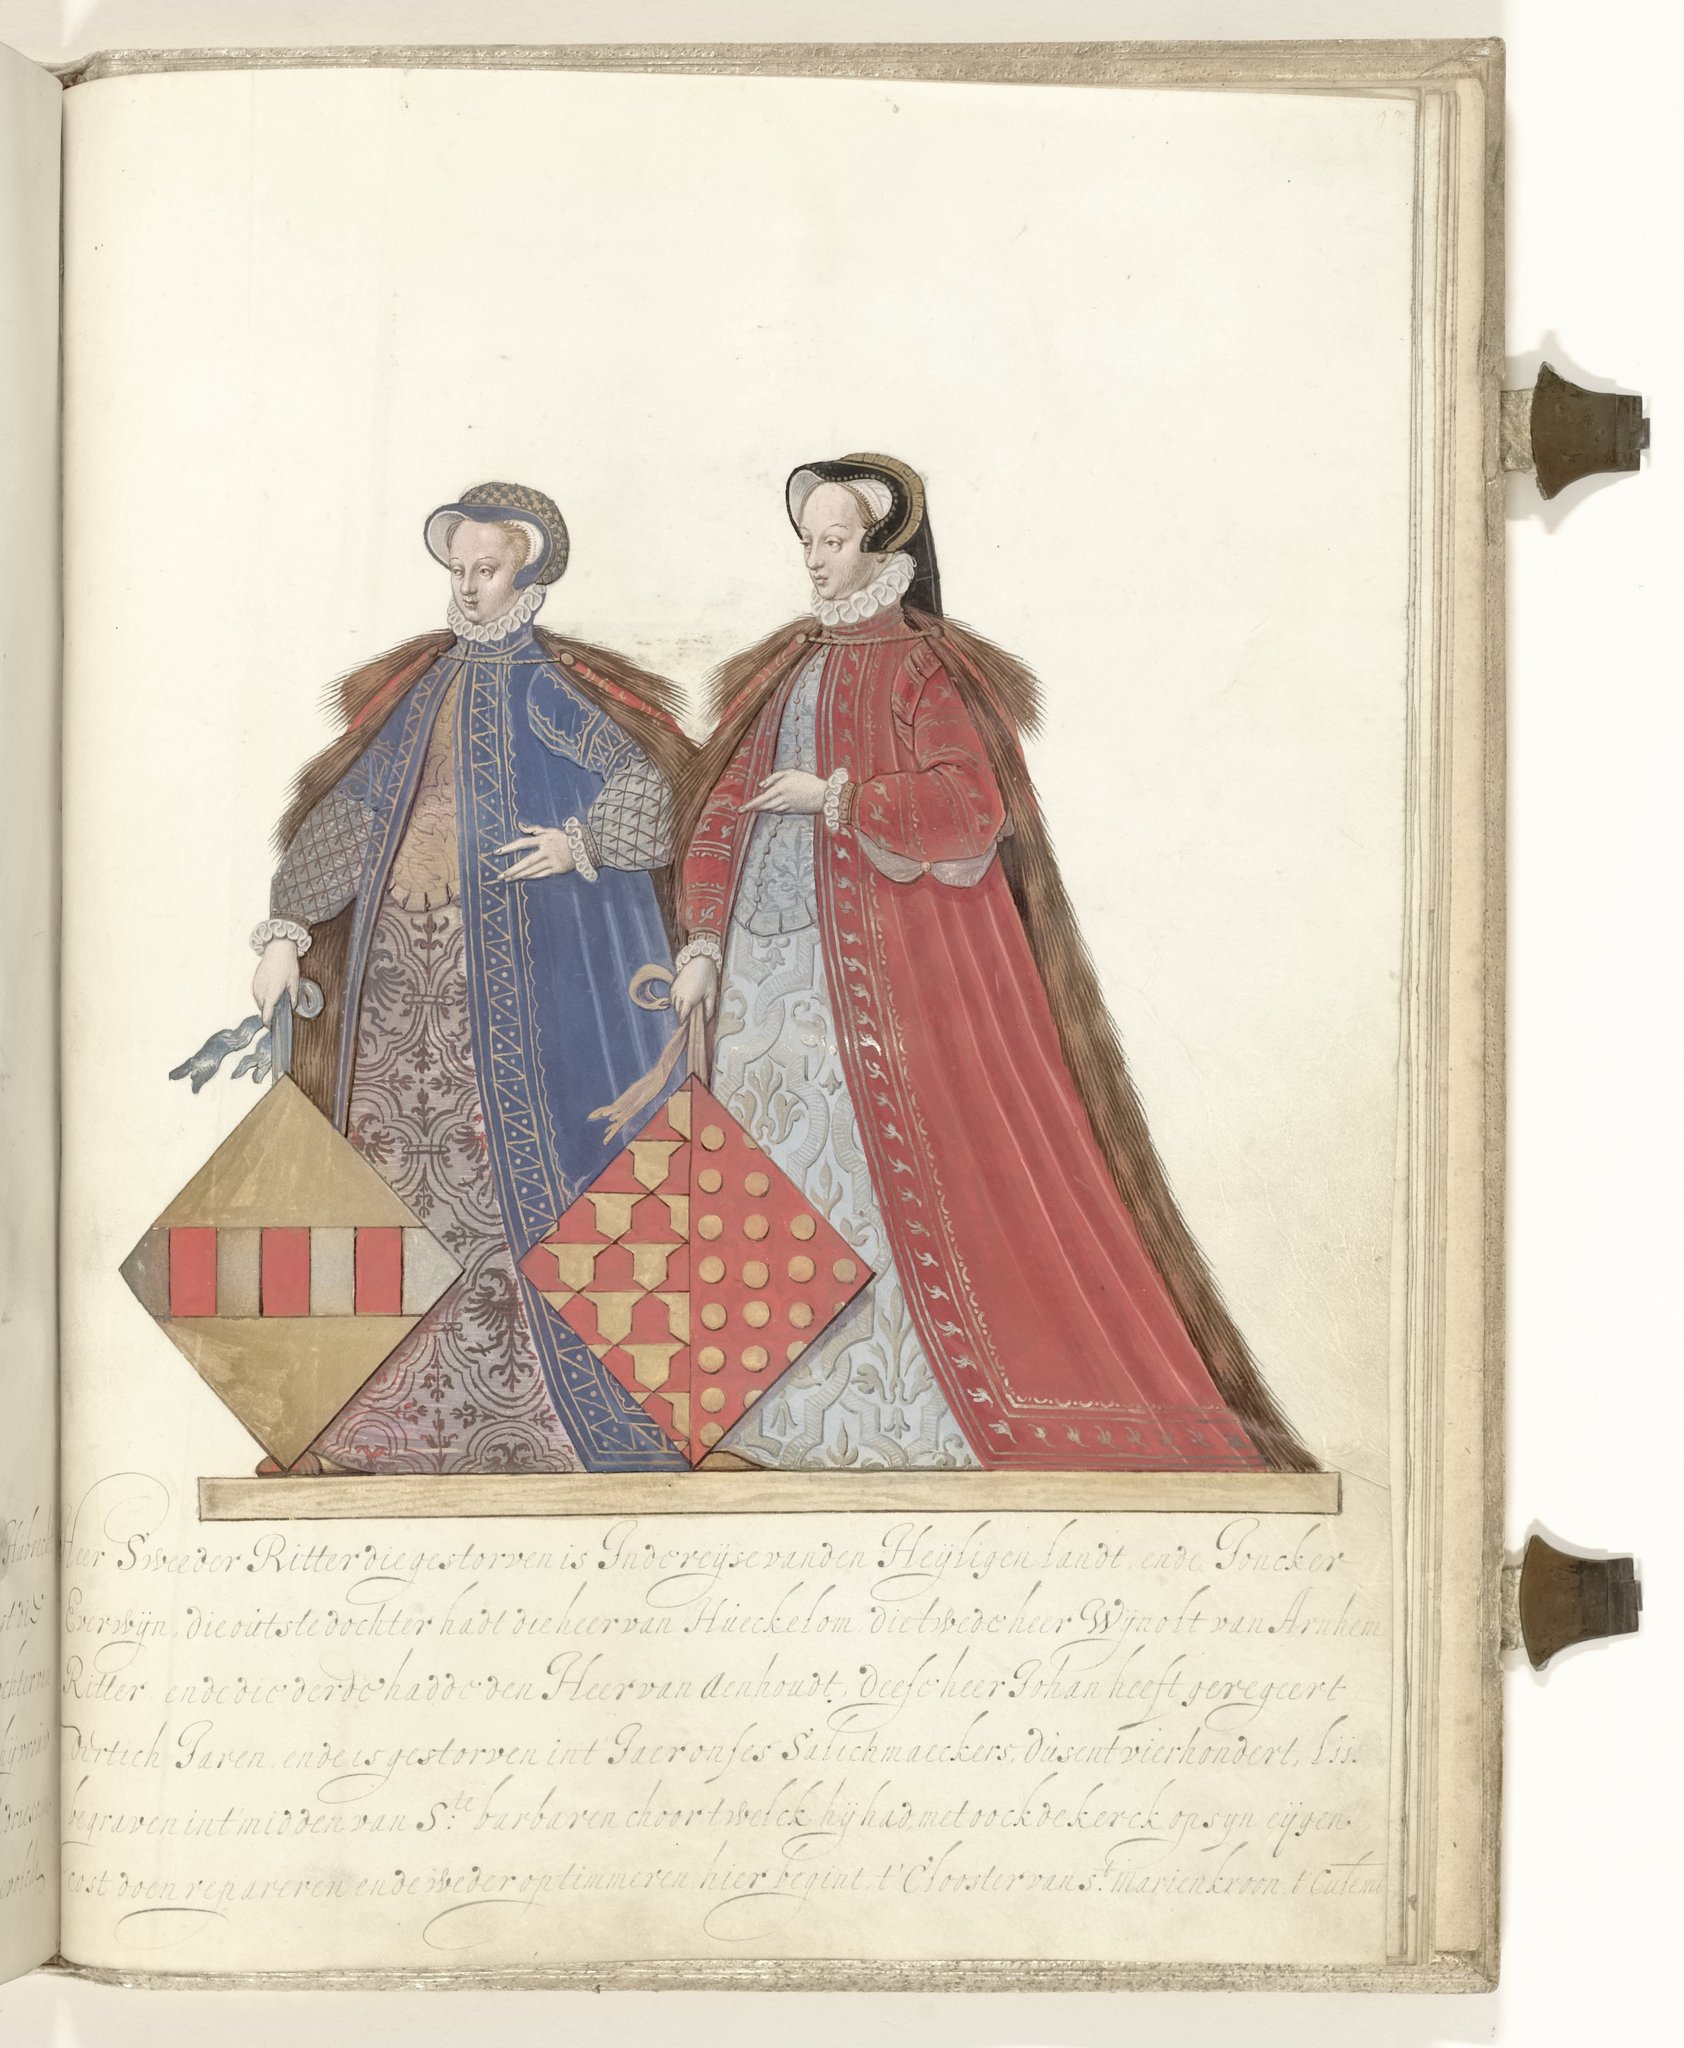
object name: drawing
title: Twee vrouwen van Culemborg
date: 1590-1593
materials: paint, gouache, ink, parchment, watercolor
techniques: writing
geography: northern netherlands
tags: culemborg, heren en graven van, barbara van gemen vrouwe van culemborg, aleid van götterswick vrouwe van culemborg, culemborg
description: Barbara van Gemen en Aleid van Götterswick. De eerste en tweede vrouw van Johan III, heer van Culemborg. Twee vrouwen, staande naast elkaar ten voeten uit met de wapens van Gemen en van Götterswick. Onderdeel van een geïllustreerd handschrift met de genealogie van de heren en graven van Culemborg.